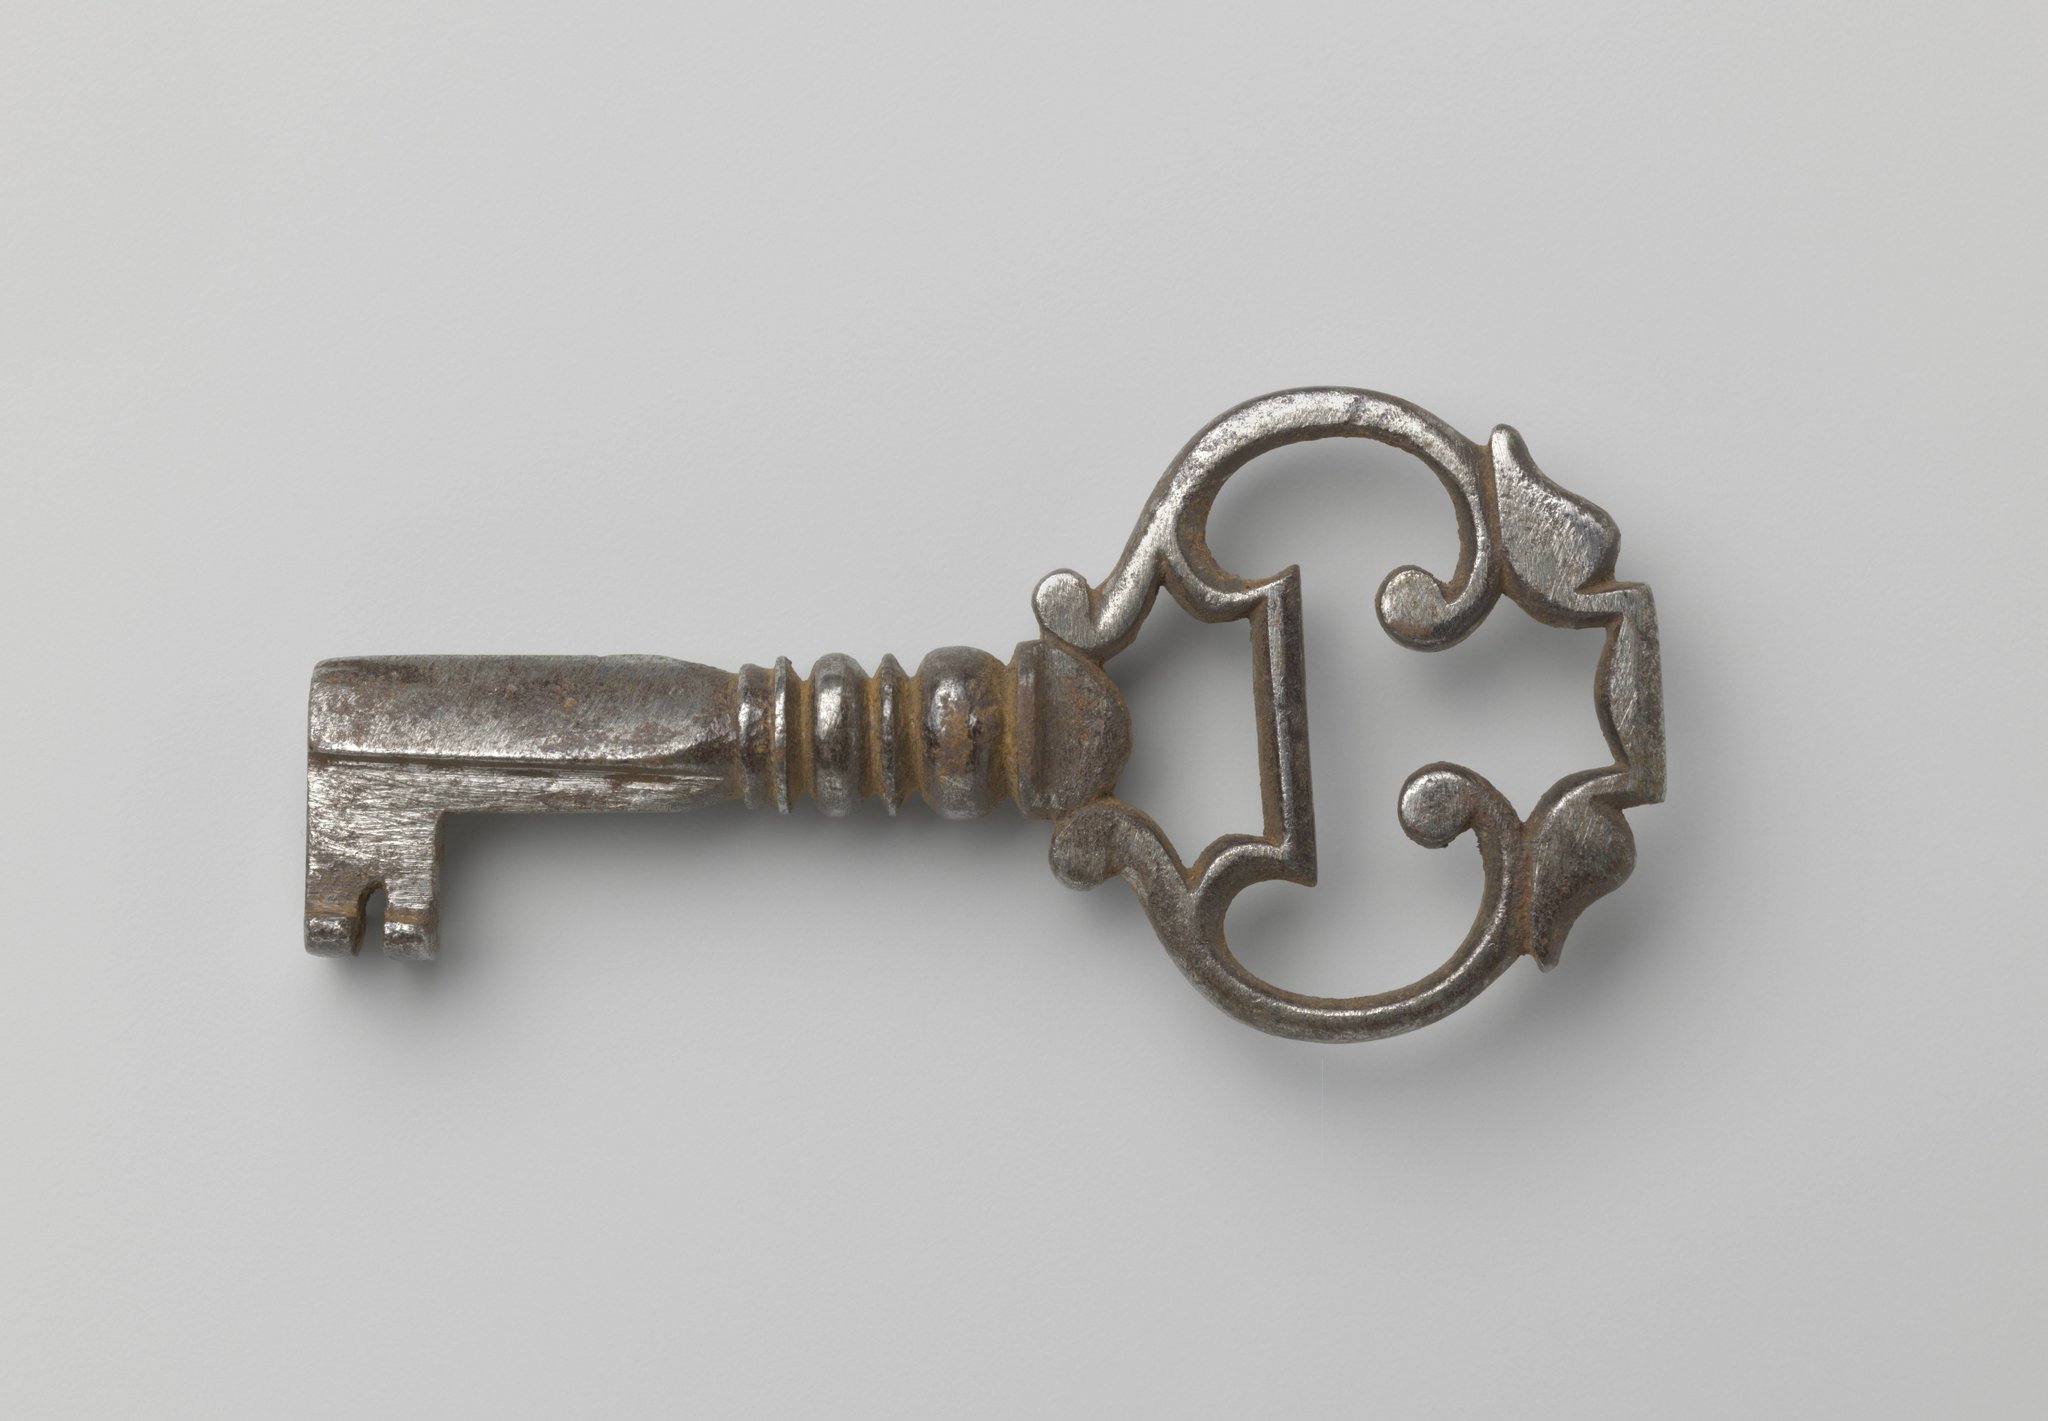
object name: key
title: Sleutel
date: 1600-1699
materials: iron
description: Sleutel waarvan de greep bestaat uit twee onderling, door middel van een staafje en twee blaadjes, verbonden en naar elkaar toegewende voluten. De schacht bestaat bovenaan uit twee tori tussen schijven en wordt vervolgens driehoekig.